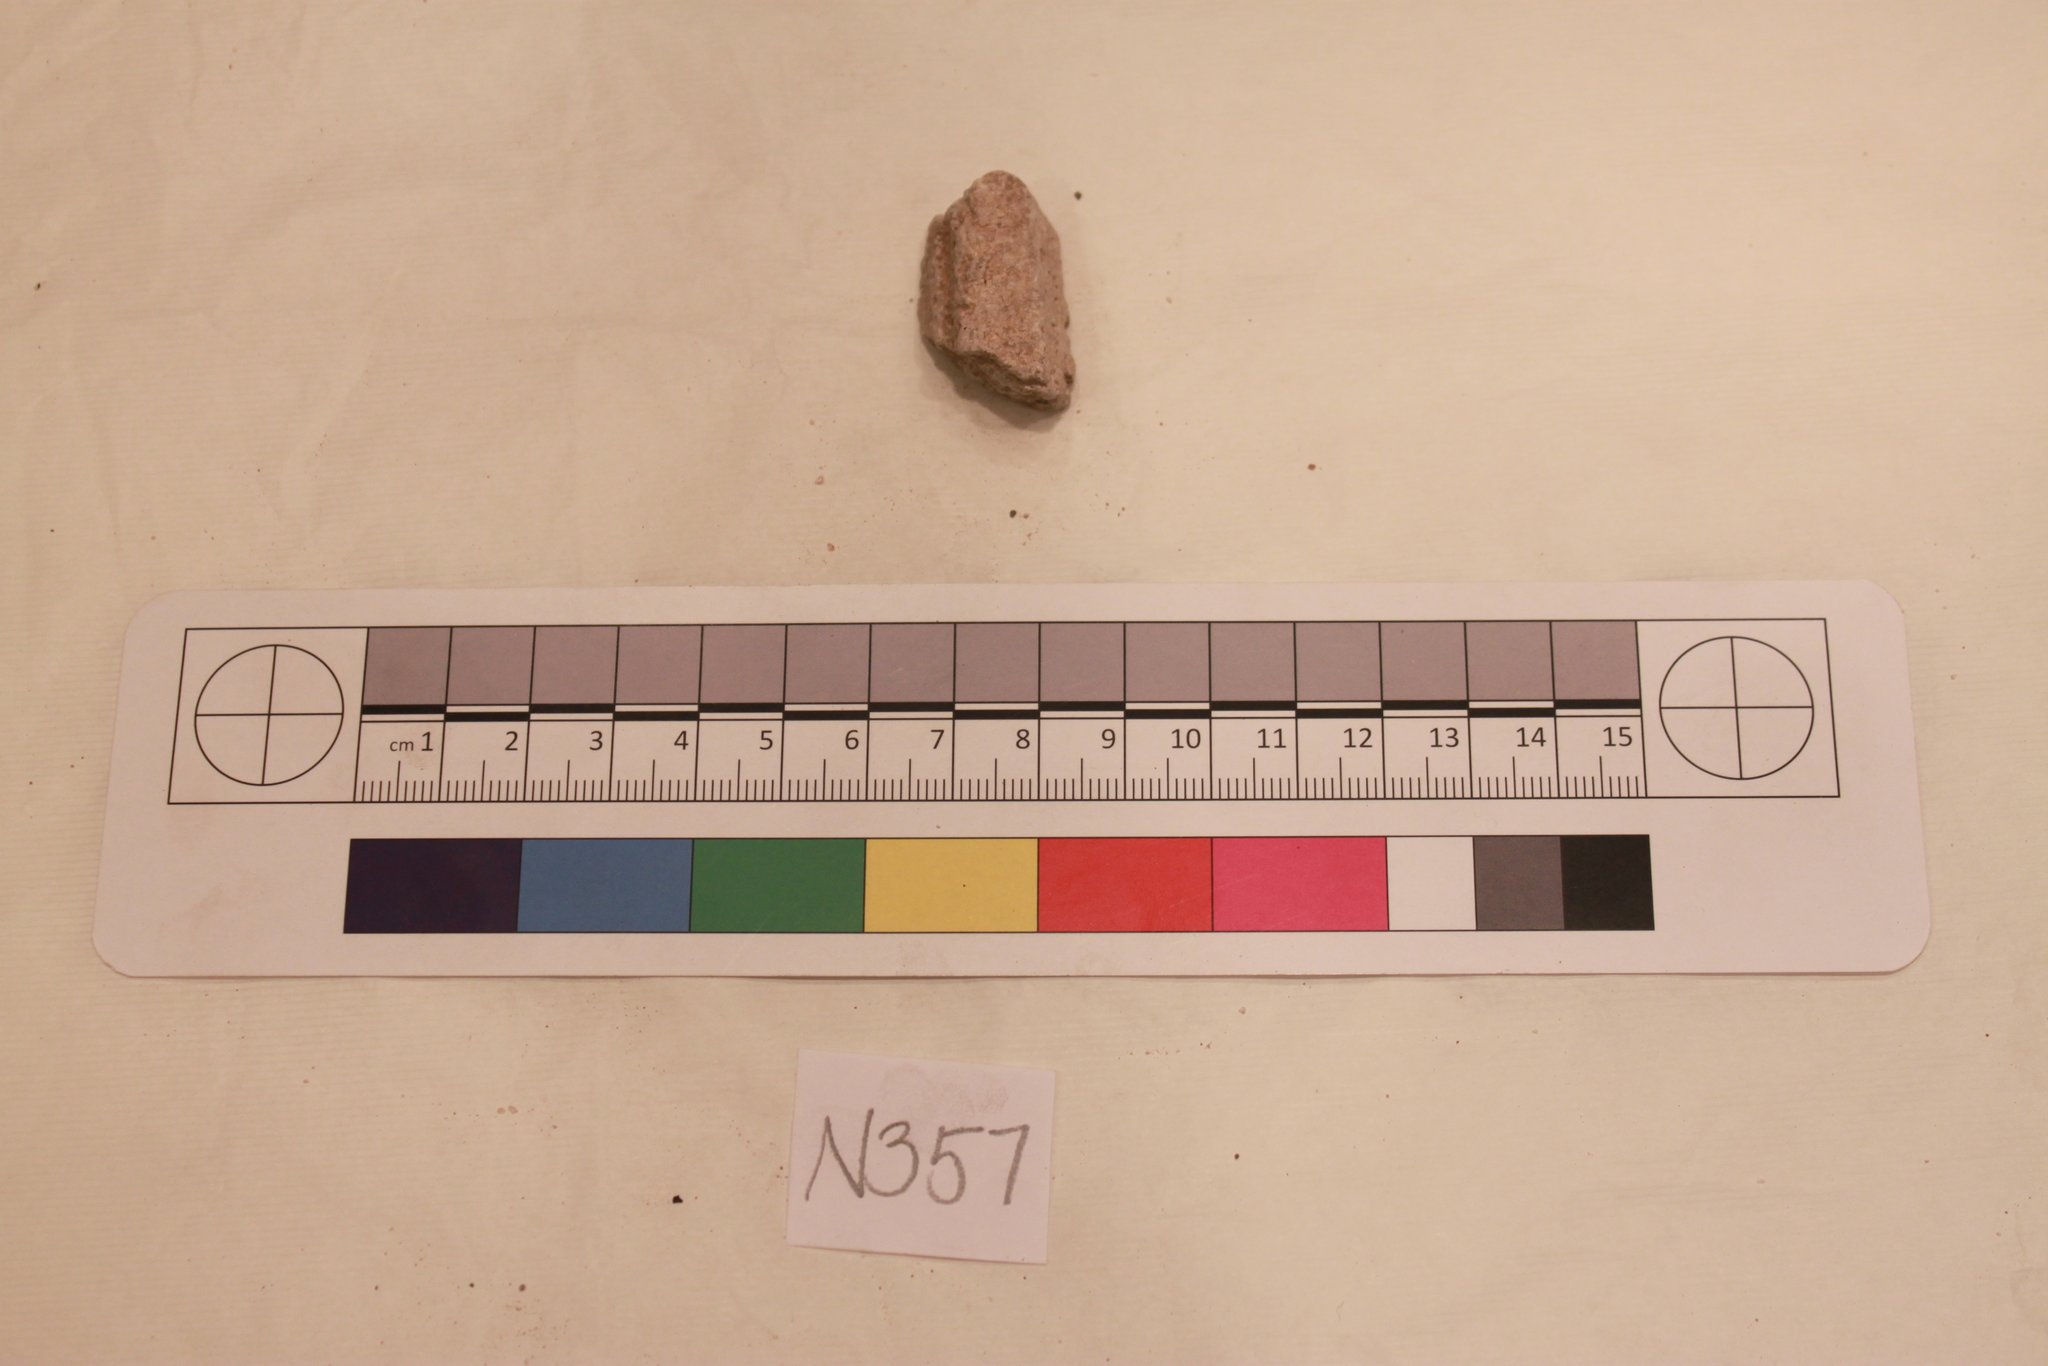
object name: fragment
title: Stucco Fragment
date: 701-1200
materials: plaster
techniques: carving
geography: iran